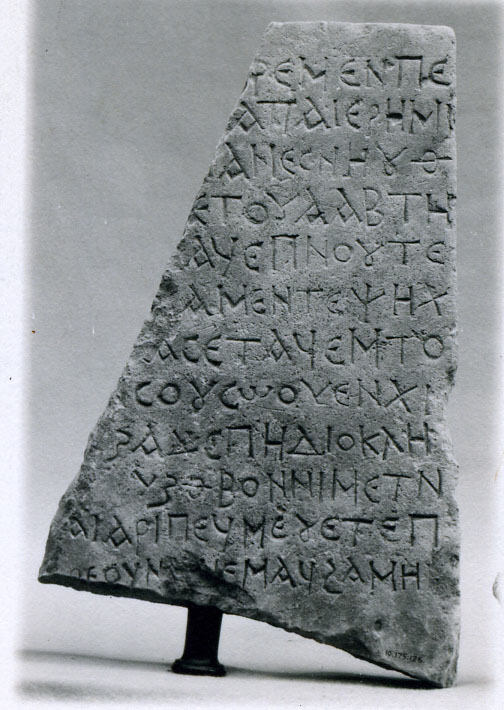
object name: fragment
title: Fragment of an Inscribed Stele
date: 501-700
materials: limestone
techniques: incising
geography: egypt